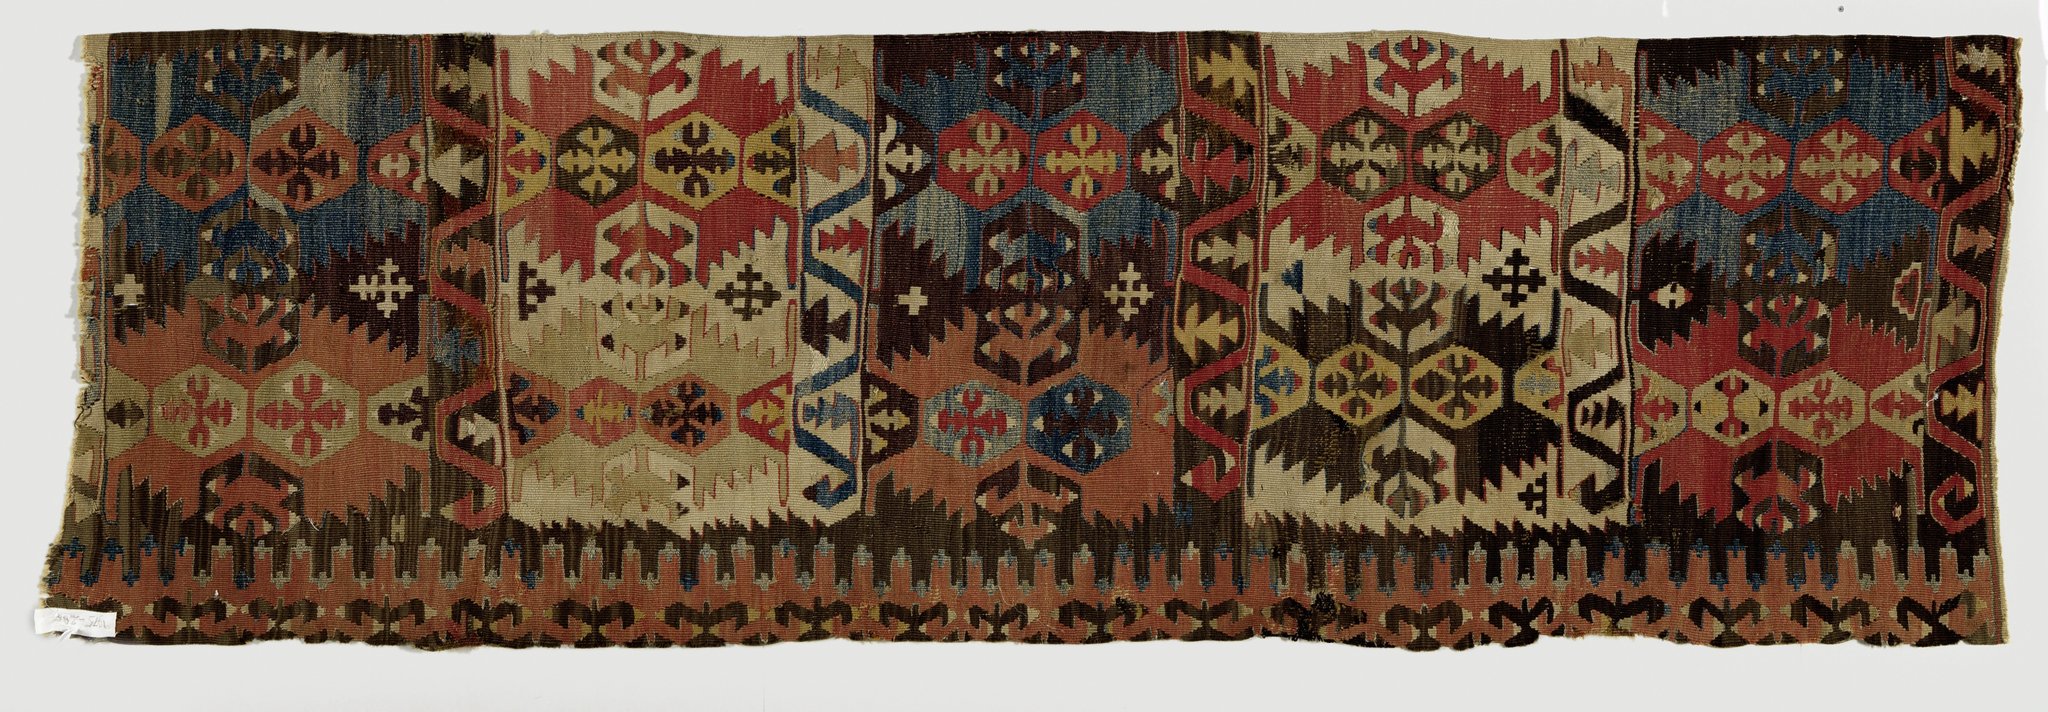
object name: oriental rug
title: Fragment van een kelim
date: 1875-1900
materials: wool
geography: asia minor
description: Fragment van een strepenkleed in kelim-techniek. Het middenveld is versierd met brede en smalle strepen. Op de brede staan zeshoeken, op de smalle ranken.